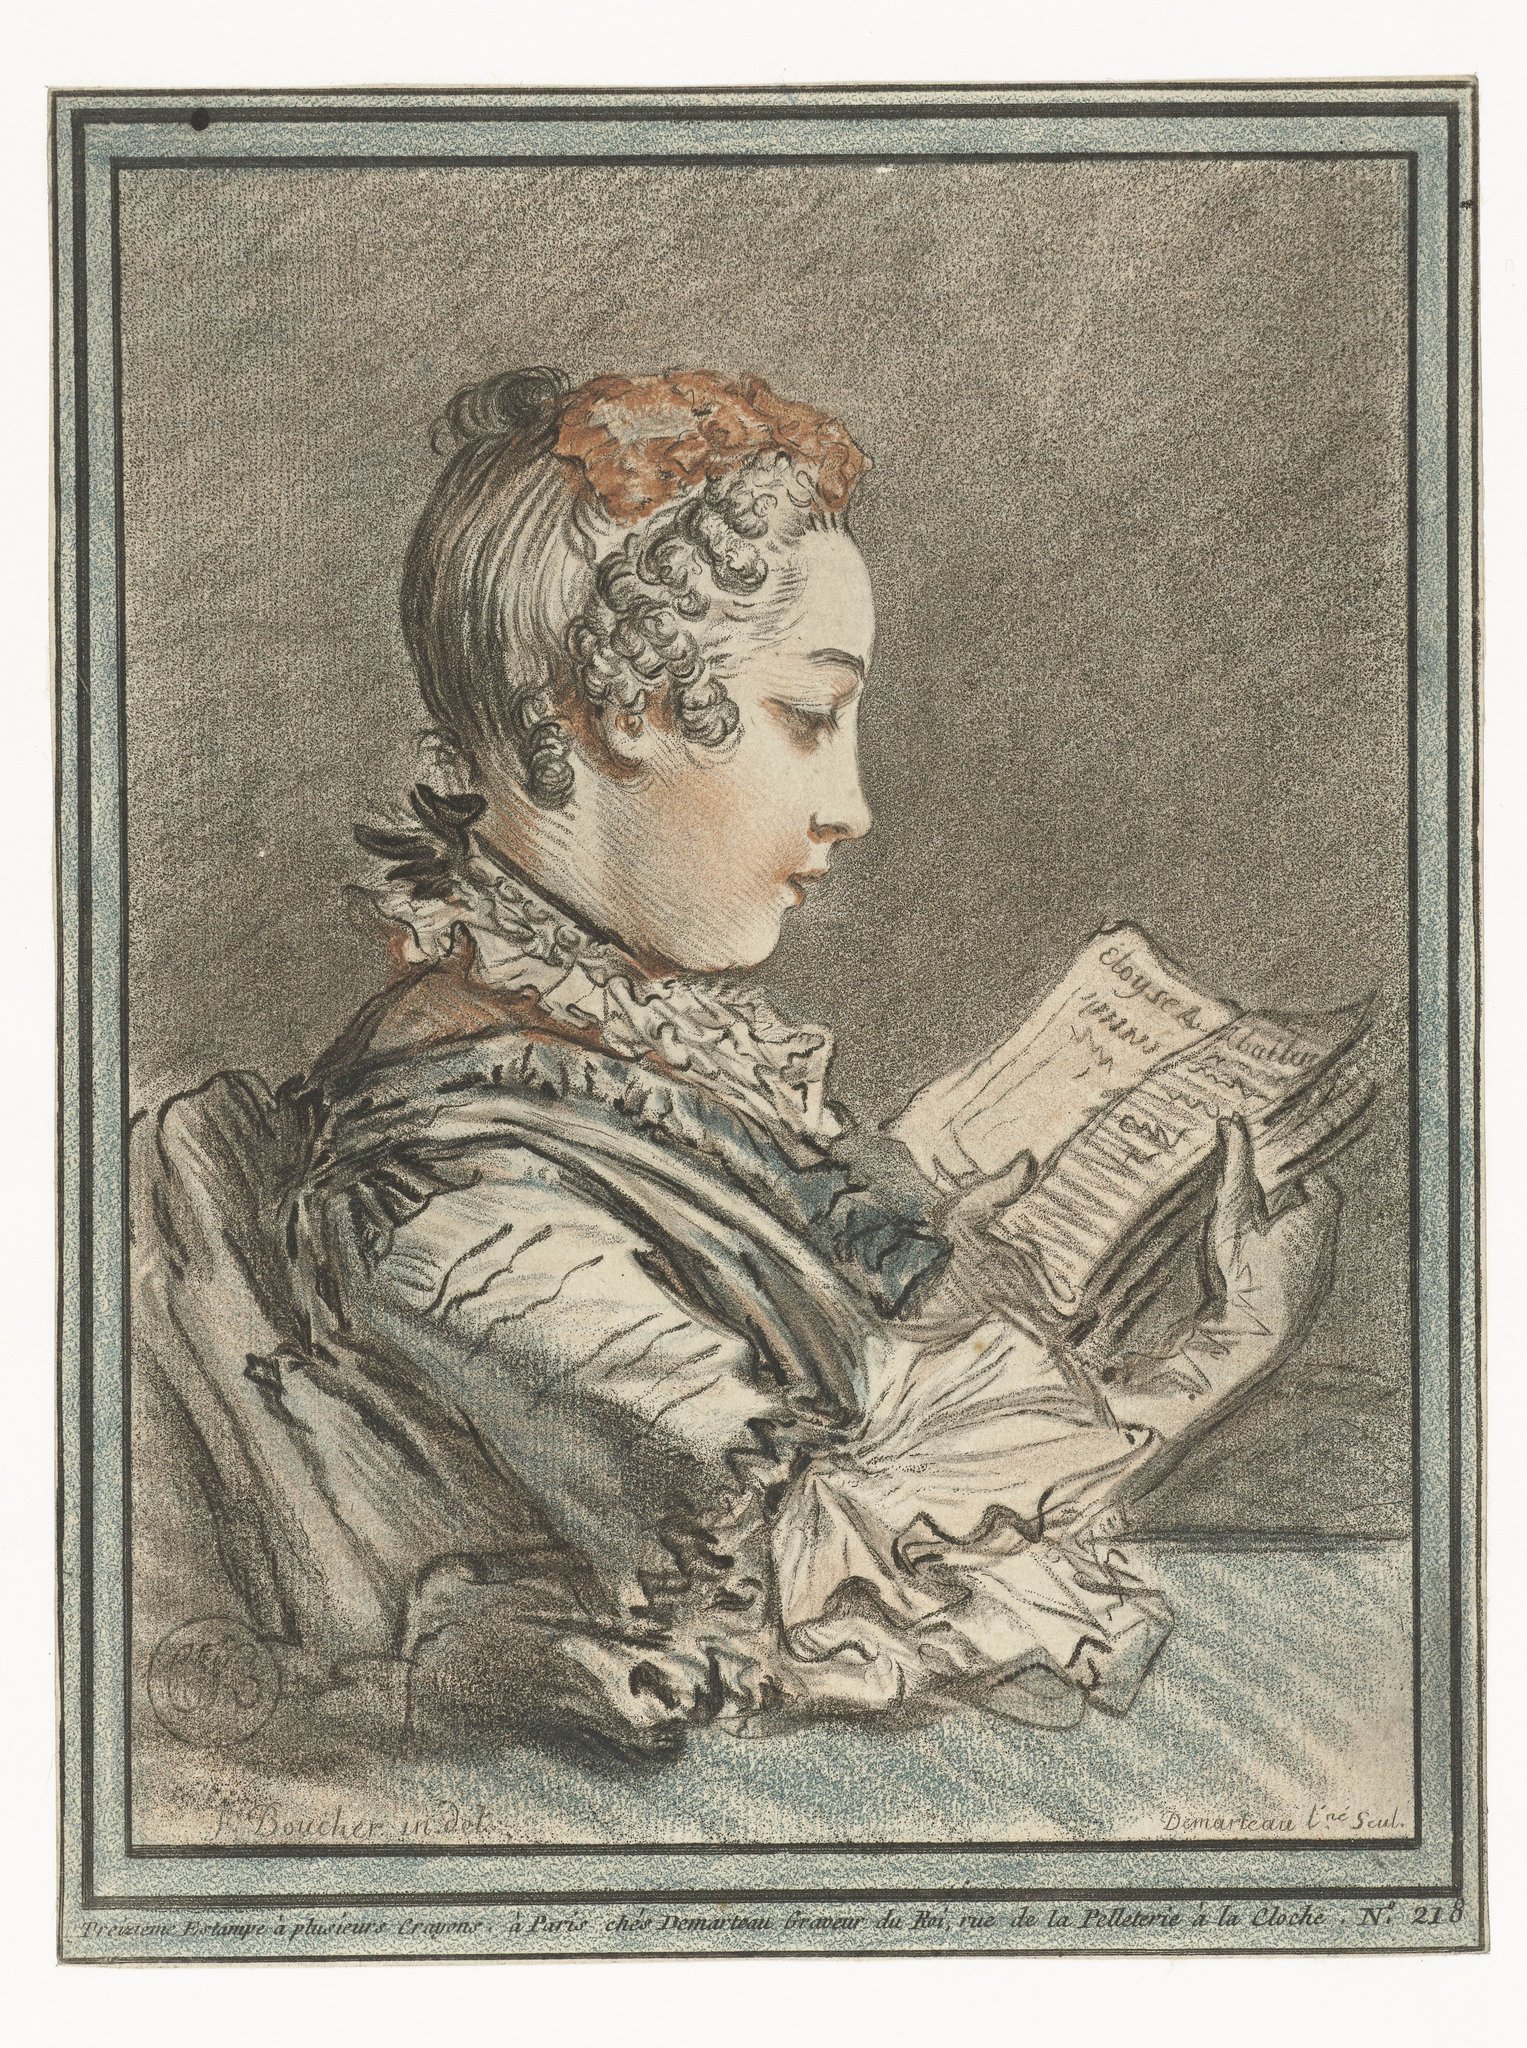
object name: print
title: Lezende vrouw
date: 1756-1776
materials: paper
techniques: printing, printmaking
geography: paris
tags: reading, adult woman (+ sideview, profile)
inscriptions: collector's mark: Lugt 2228, number: ‘No. 218’, collector's mark: Lugt 581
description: Een vrouw, van de zijkant gezien, zittend aan een tafel en lezend in de brieven van Heloise aan Abelard.